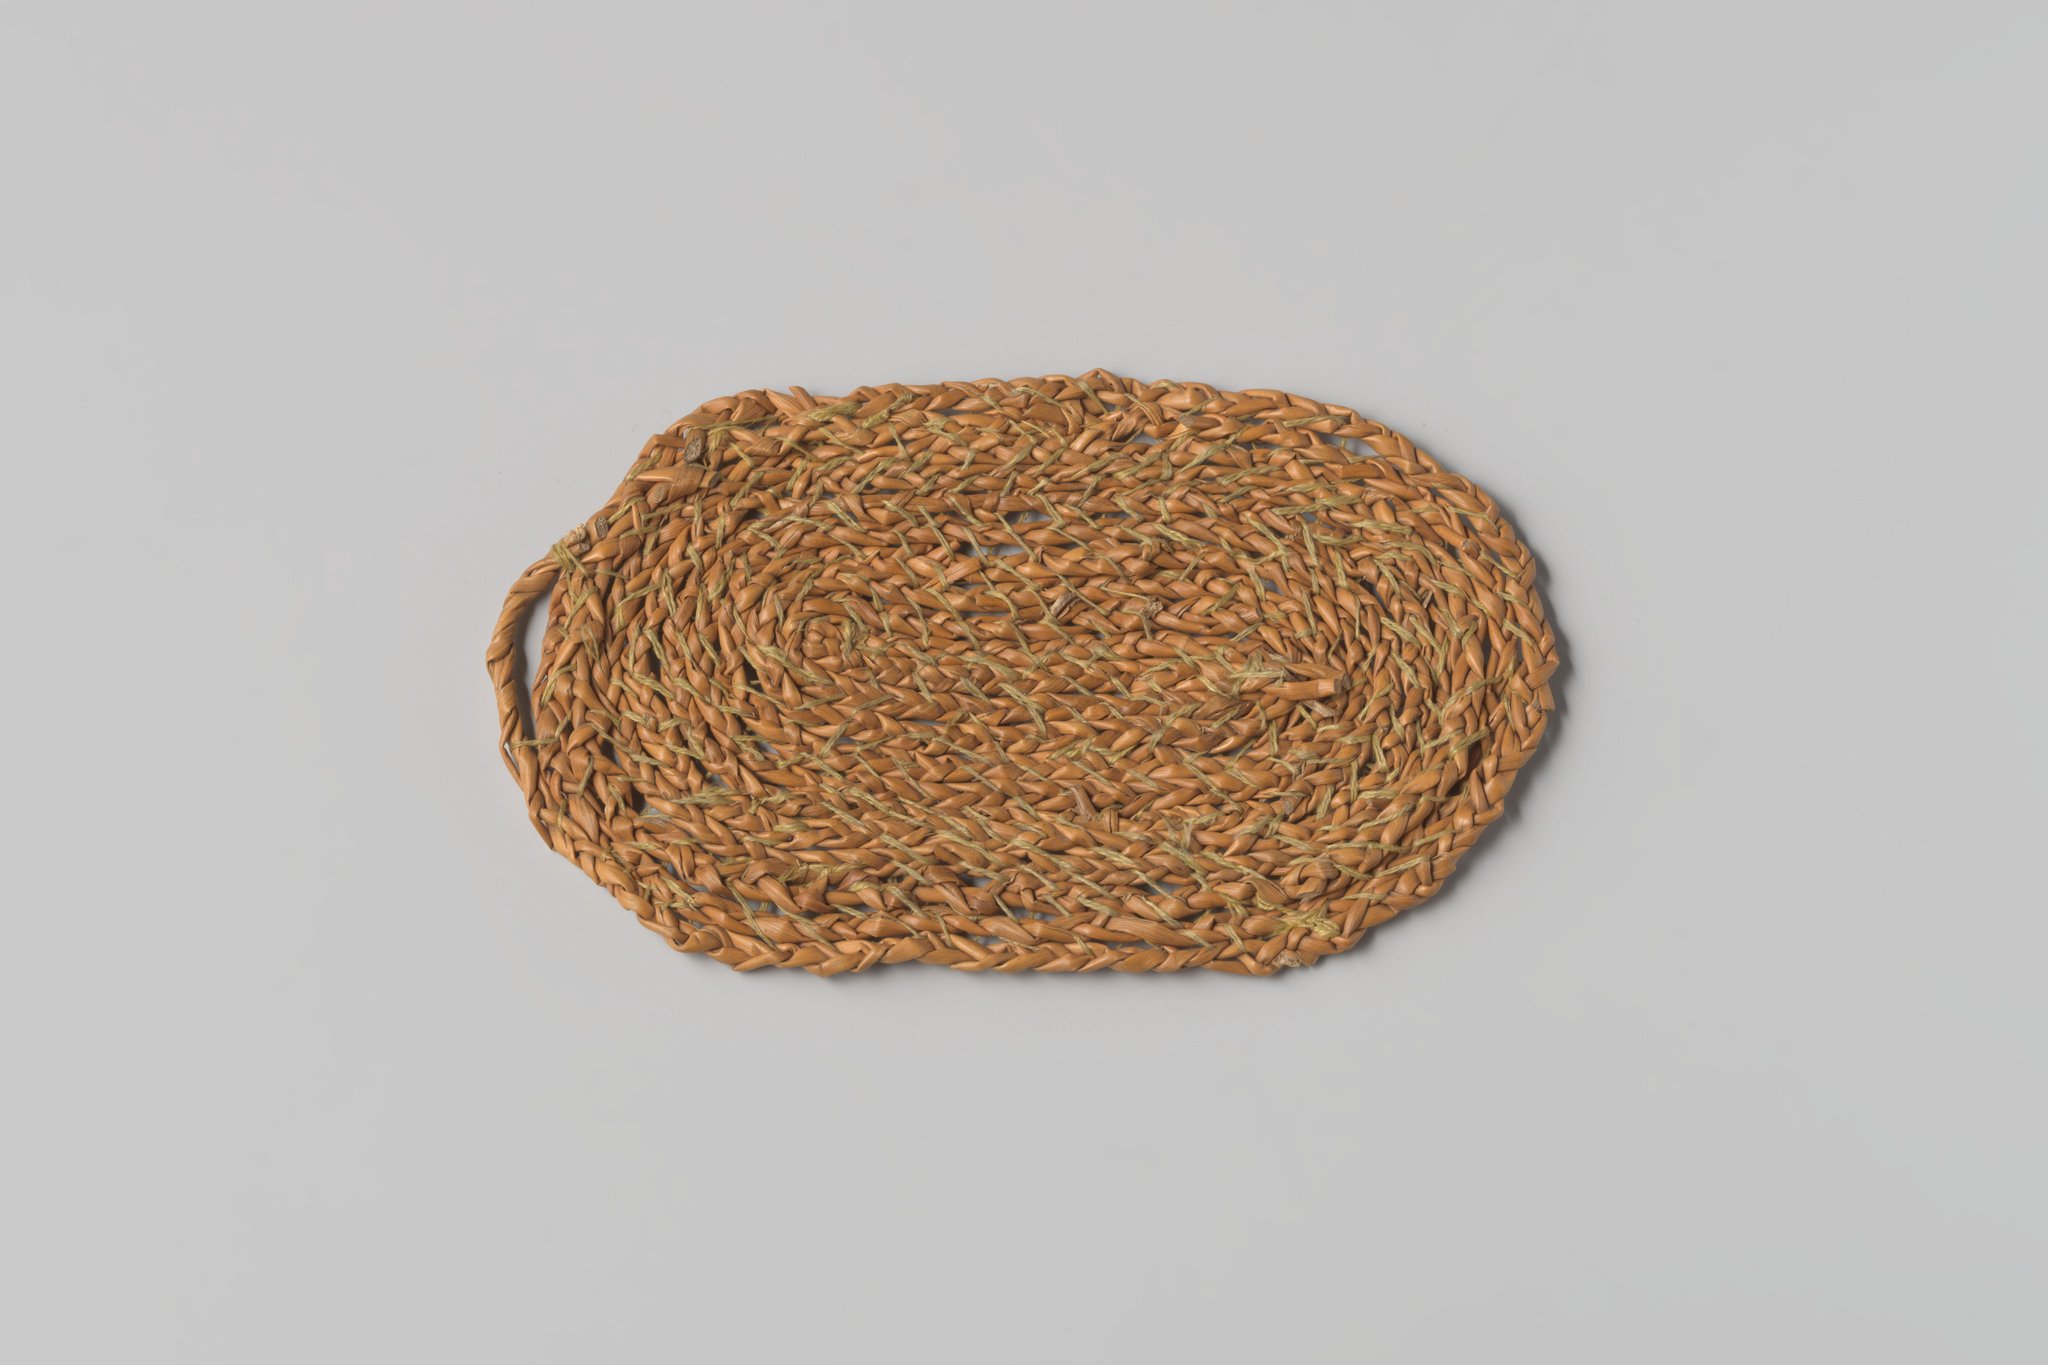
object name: vloermat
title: Vloermat, ovaal, van mattenbies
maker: Anonymous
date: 1600-1699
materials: silk, fiber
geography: netherlands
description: Vloermat, ovaal, van mattenbies. Vervaardigd uit één lange vlecht die rondom doorlopend met zijden draad is vastgezet. Aan het einde is een handvat opengelaten.